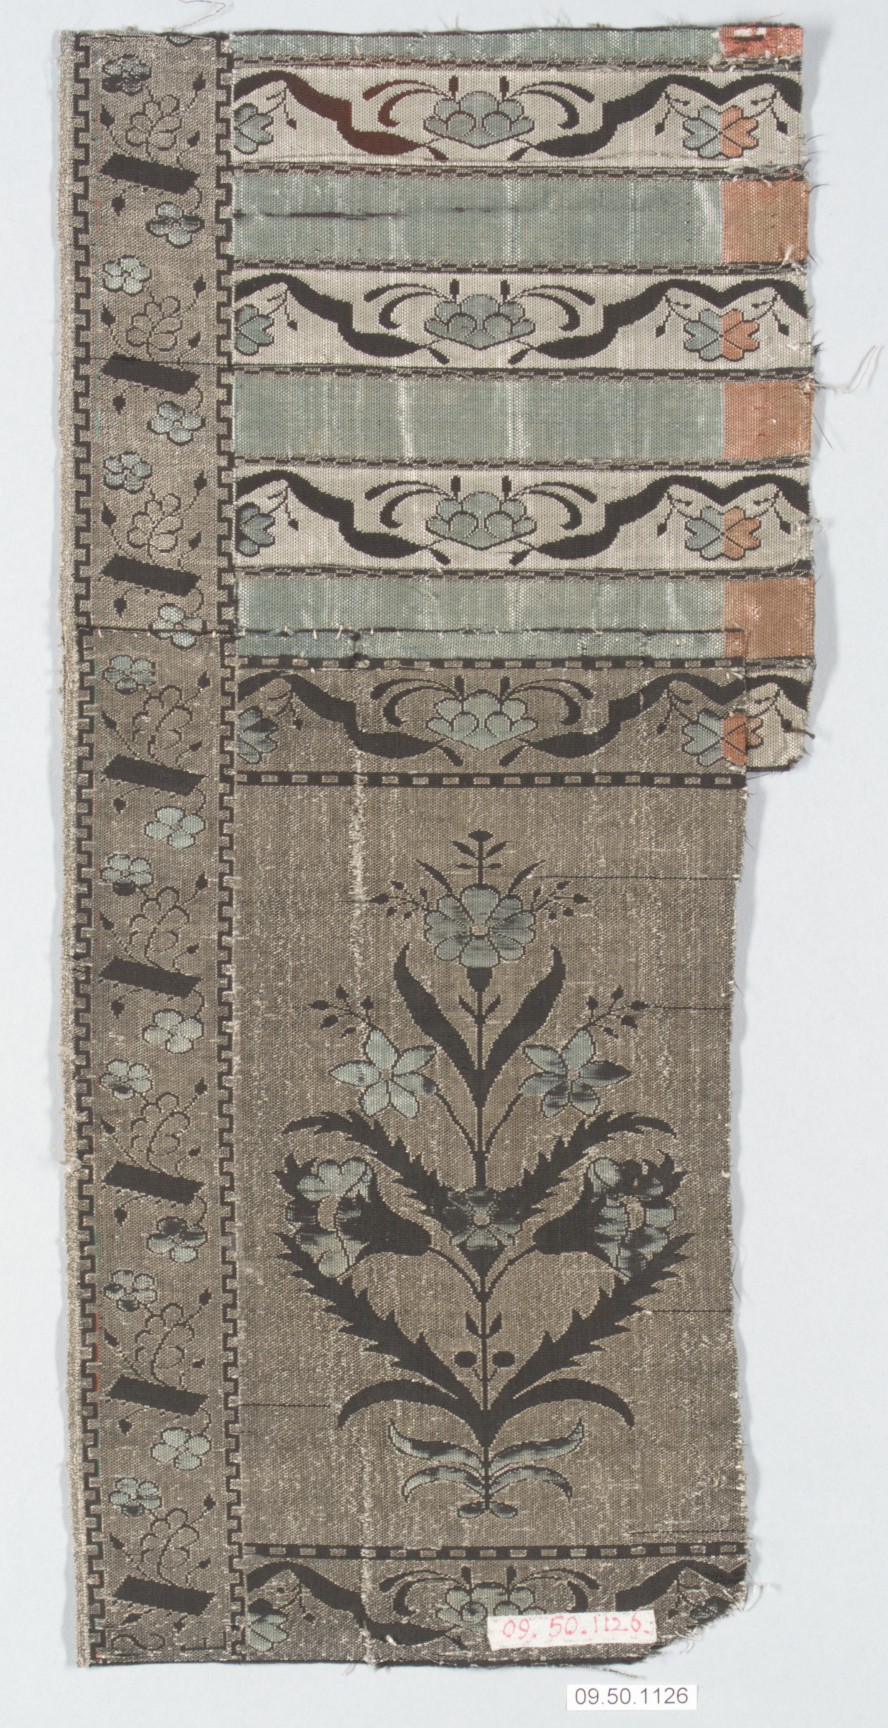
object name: fragment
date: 1701-1800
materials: metal thread, silk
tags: flowers,leaves